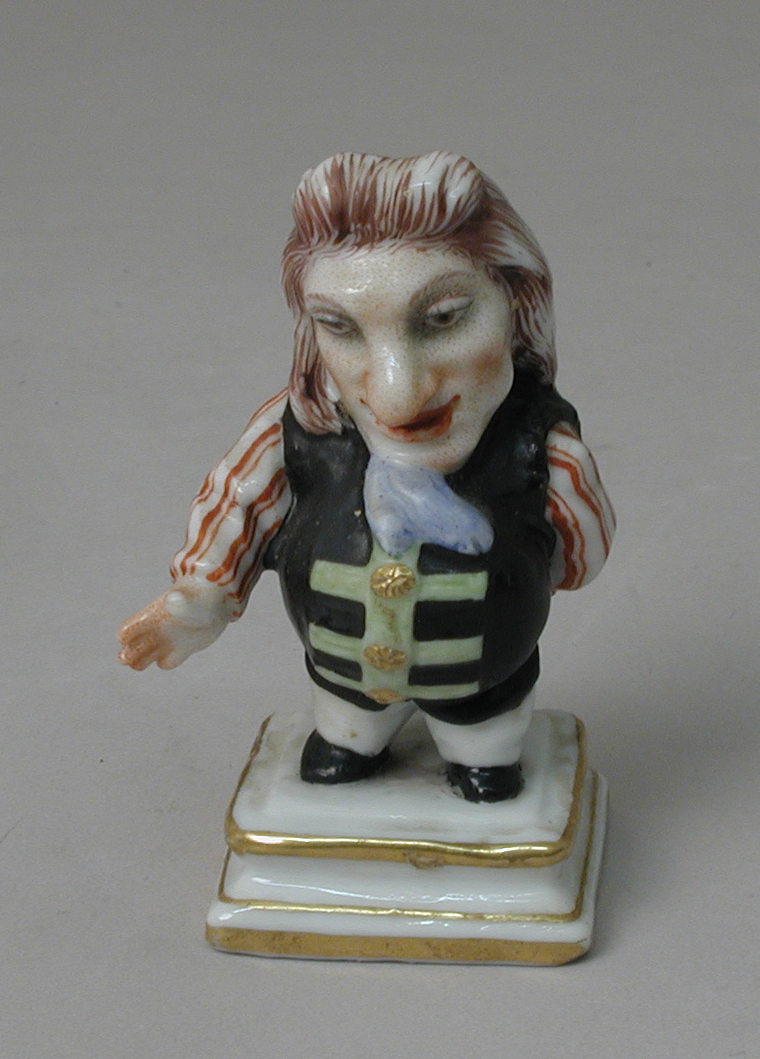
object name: figure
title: Dwarf (one of three)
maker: doccia porcelain manufactory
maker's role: manufactory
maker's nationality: italian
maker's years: 1737-1896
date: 1760-1770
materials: soft paste porcelain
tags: men